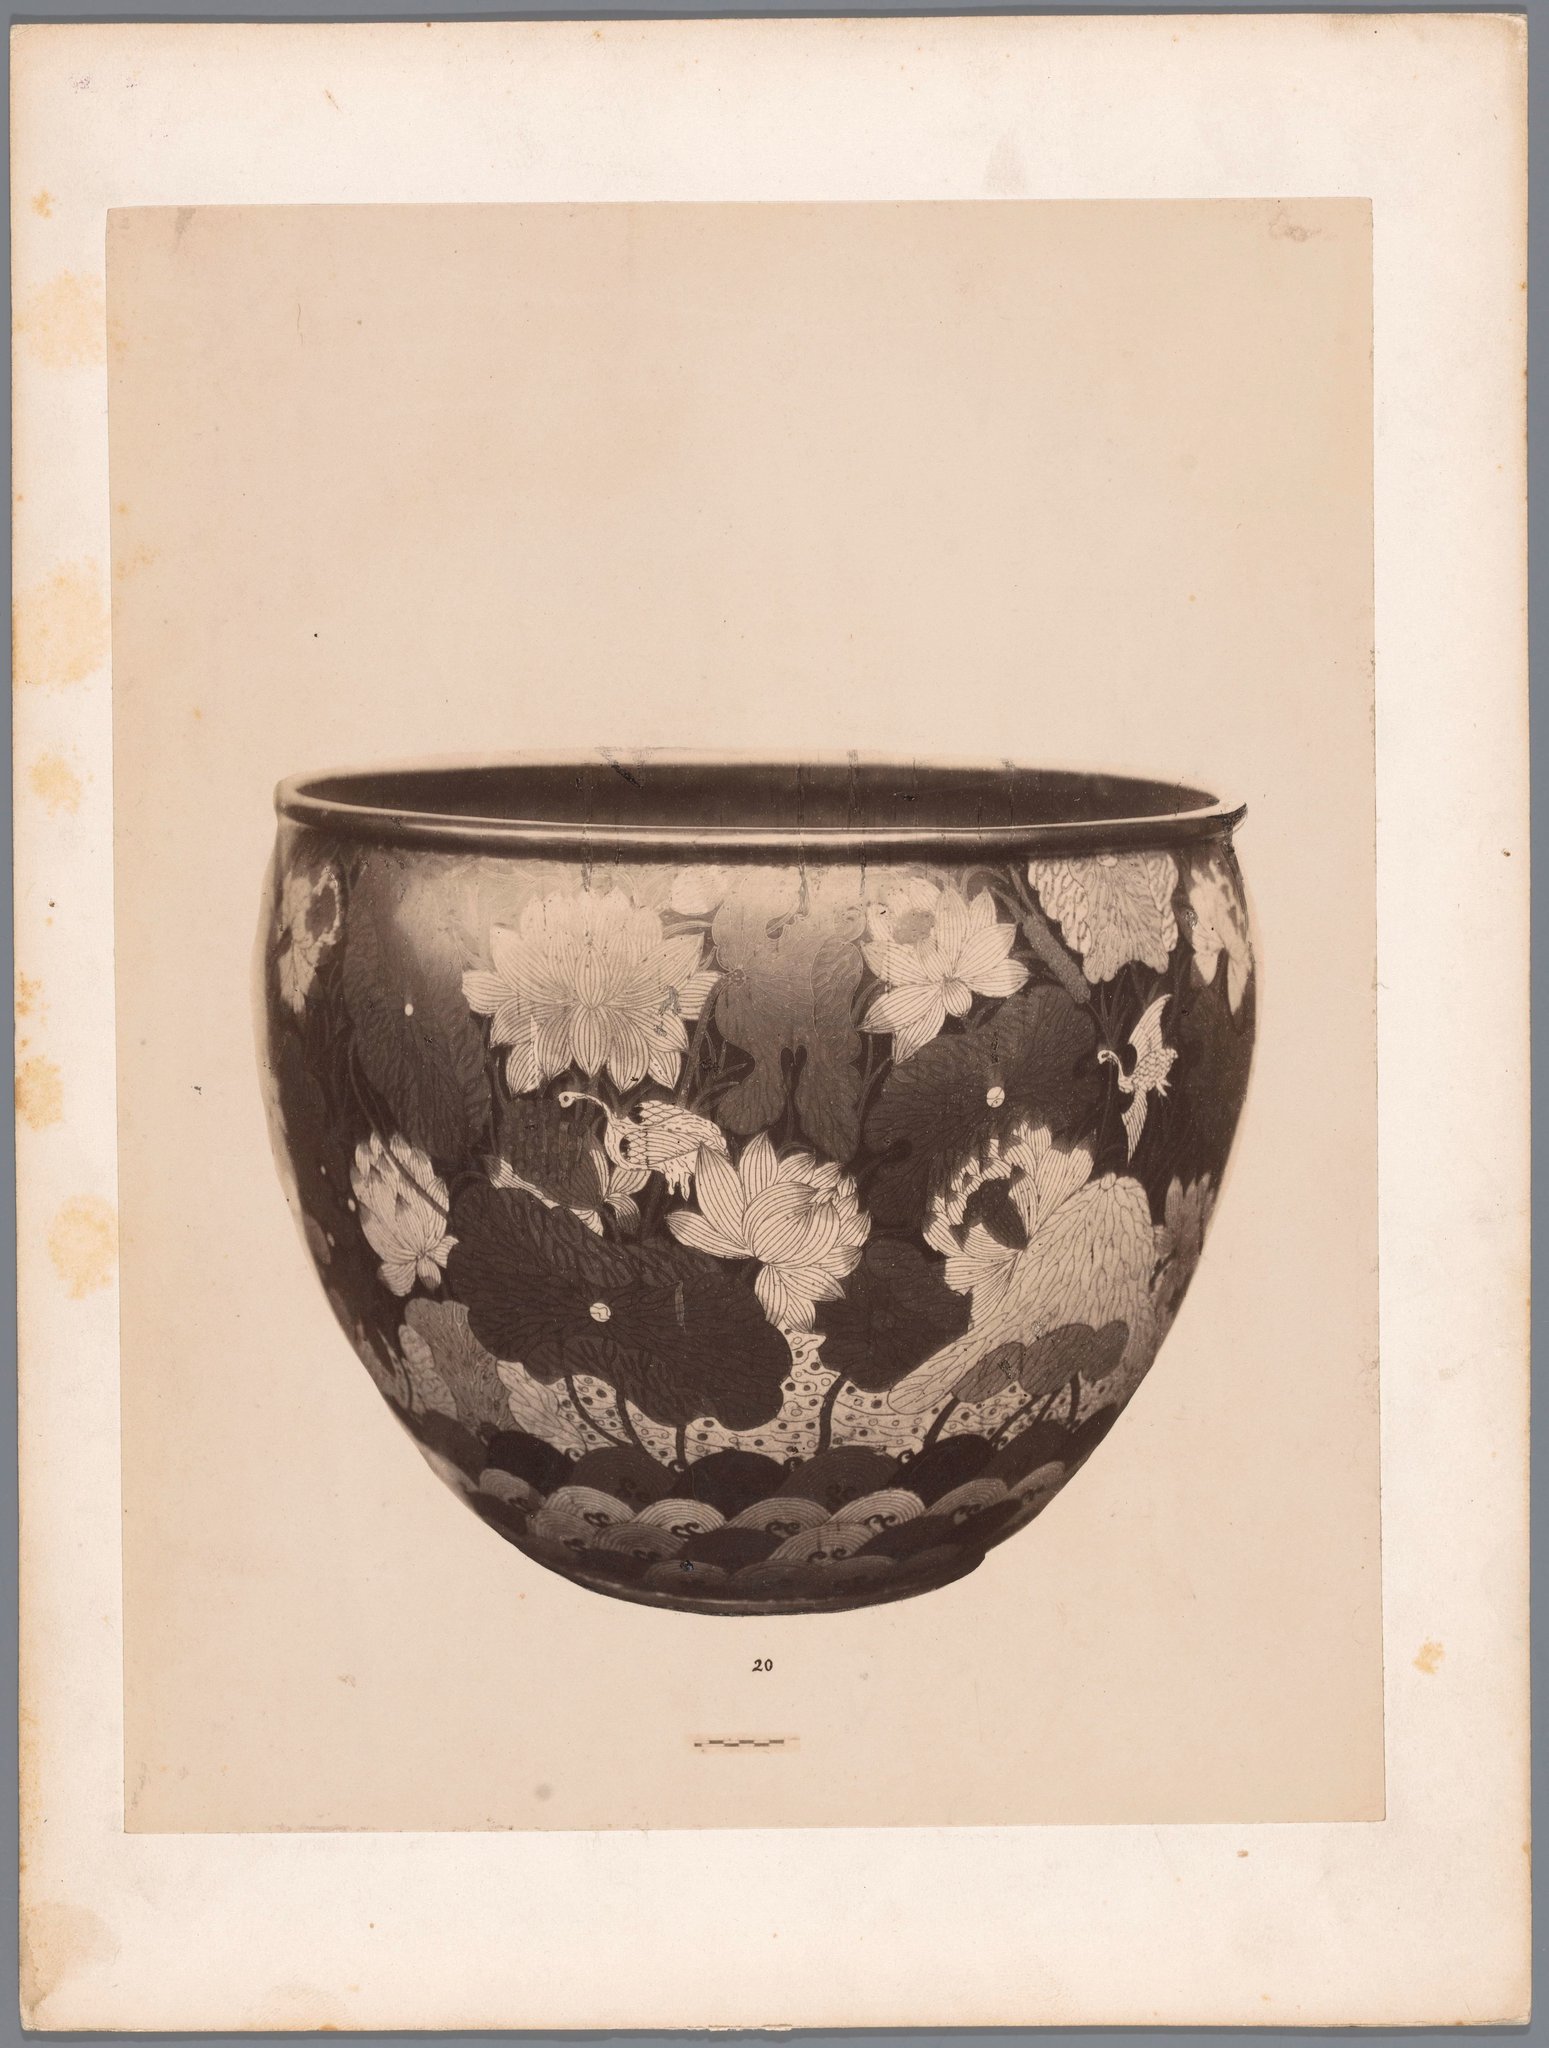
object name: photograph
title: Vaas of bloempot gedecoreerd met bloemmotieven en vermoedelijk kraanvogels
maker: Anonymous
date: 1875-1900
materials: cardboard, photographic support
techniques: albumen print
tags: applied arts, arts and crafts; industrial design, ornamental birds, container of ceramics: jar, jug, pot, vase, flowers ~ ornament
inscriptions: number: ‘20’, collector's mark: Lugt 3937